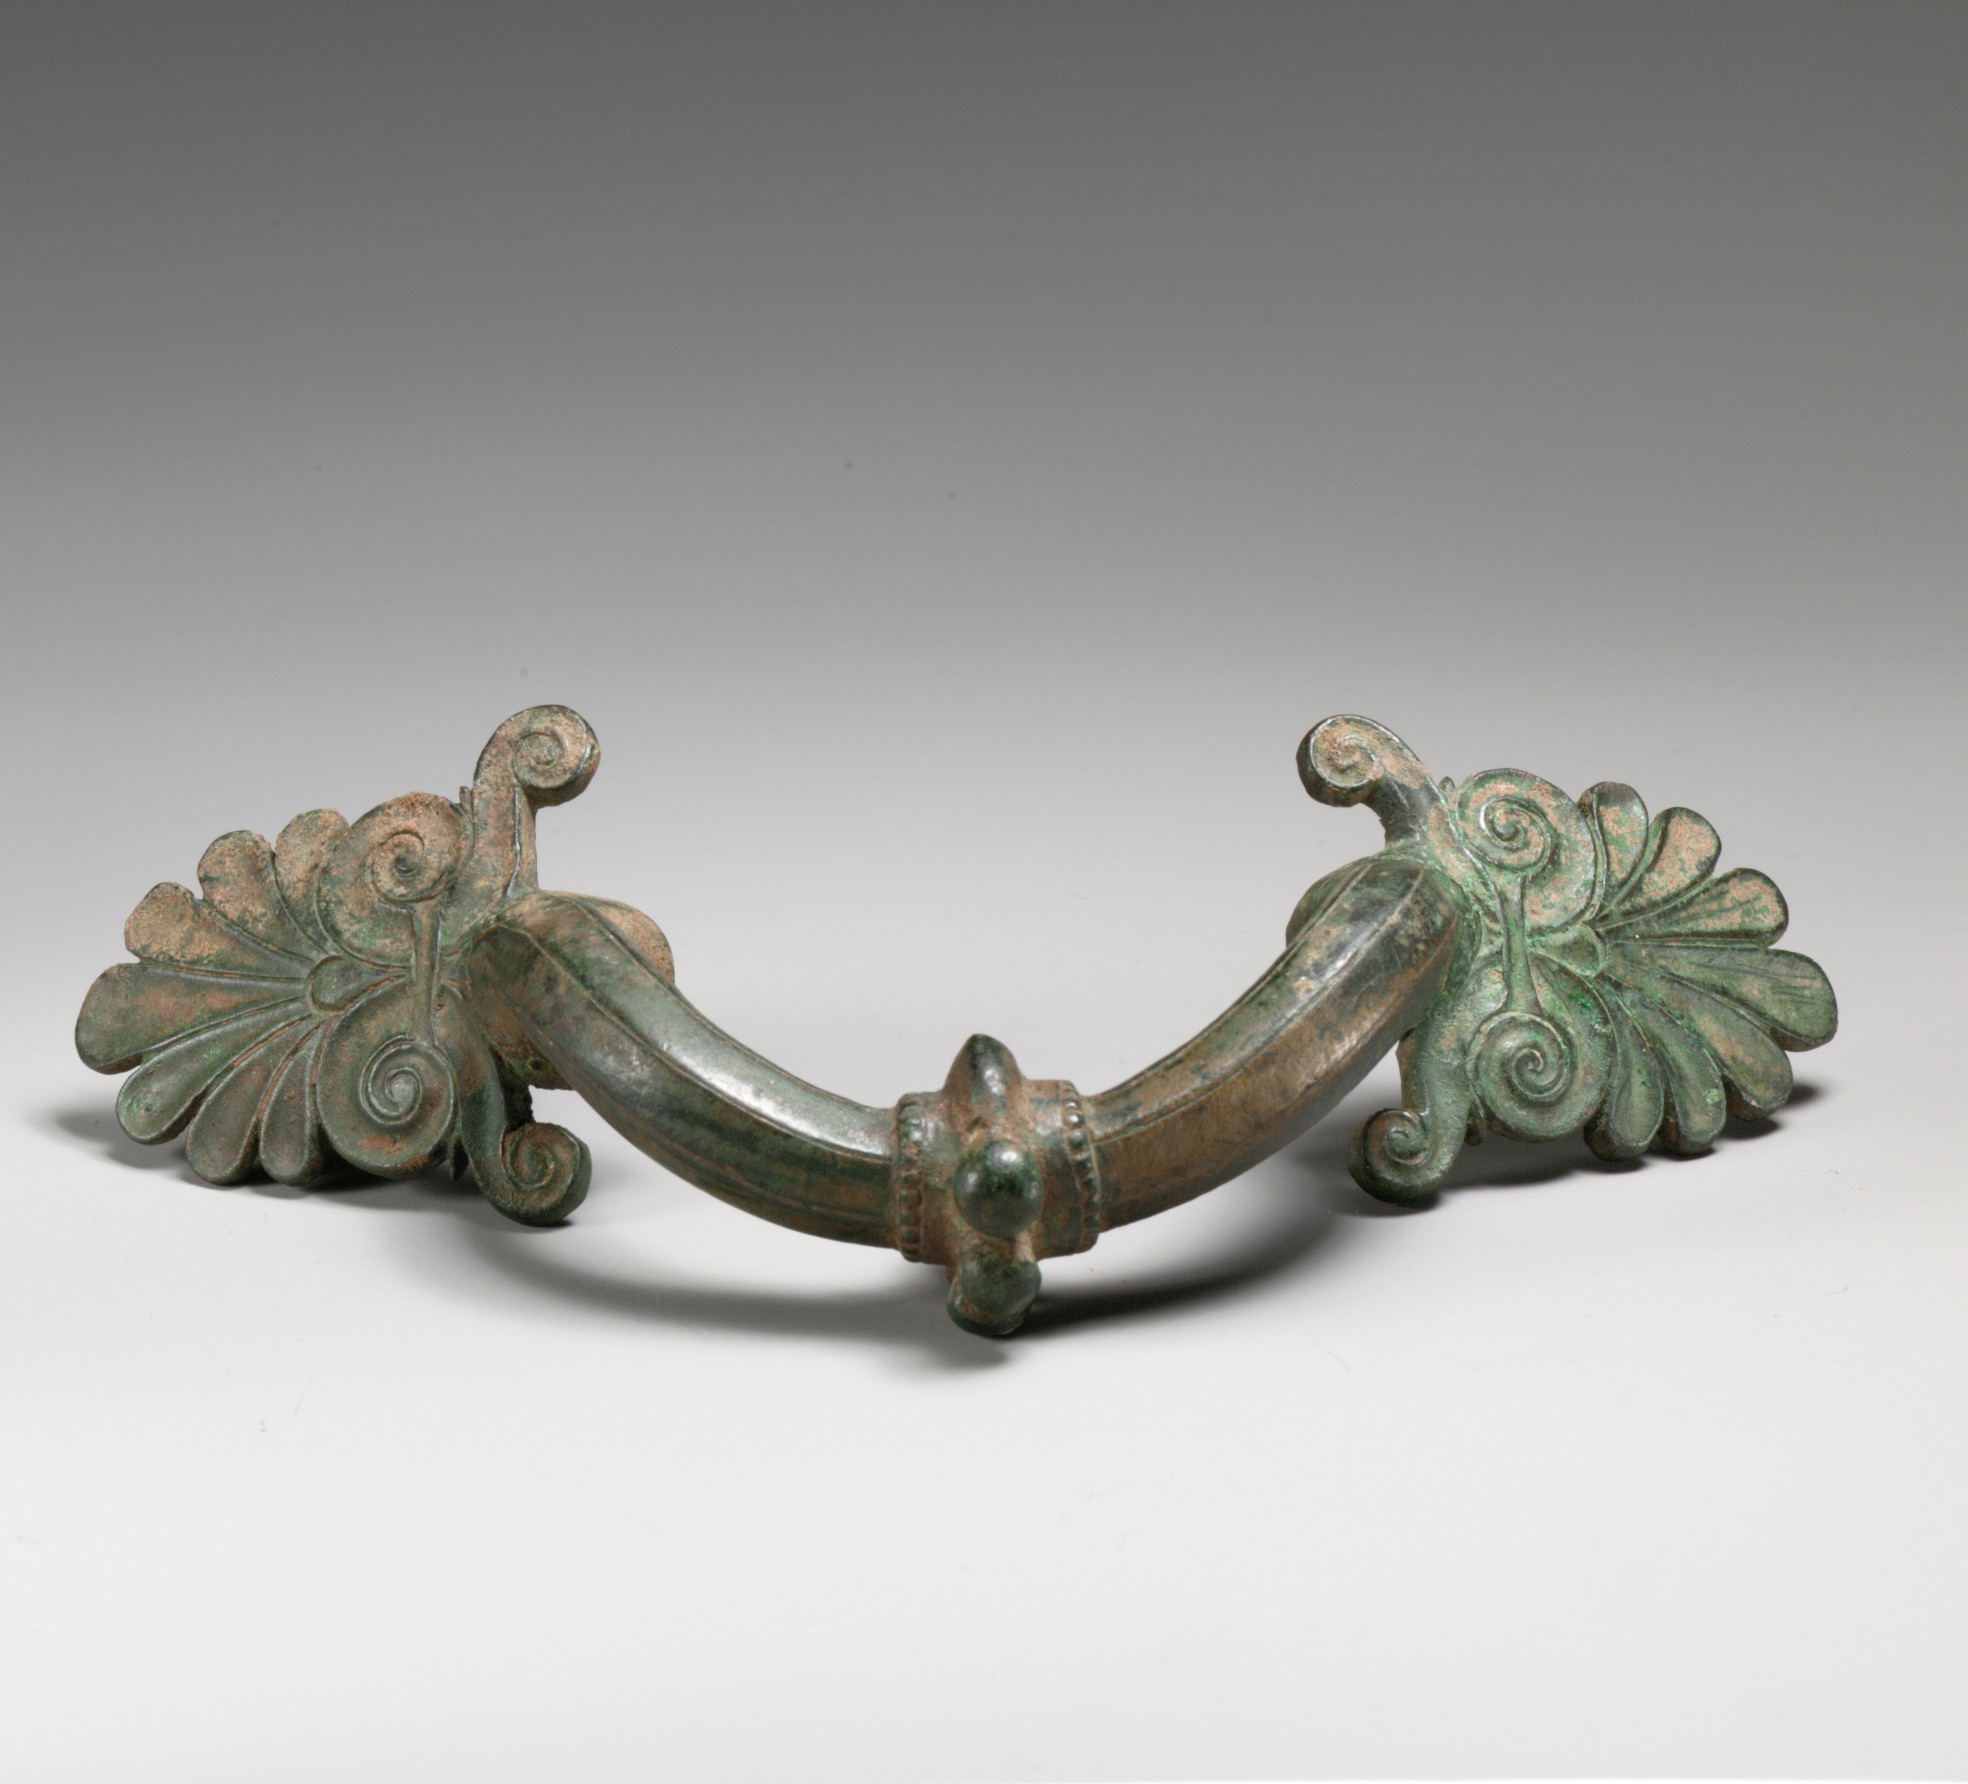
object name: handle of a hydria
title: Bronze handles of a hydria (water jar)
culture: greek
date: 500-468 BCE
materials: bronze